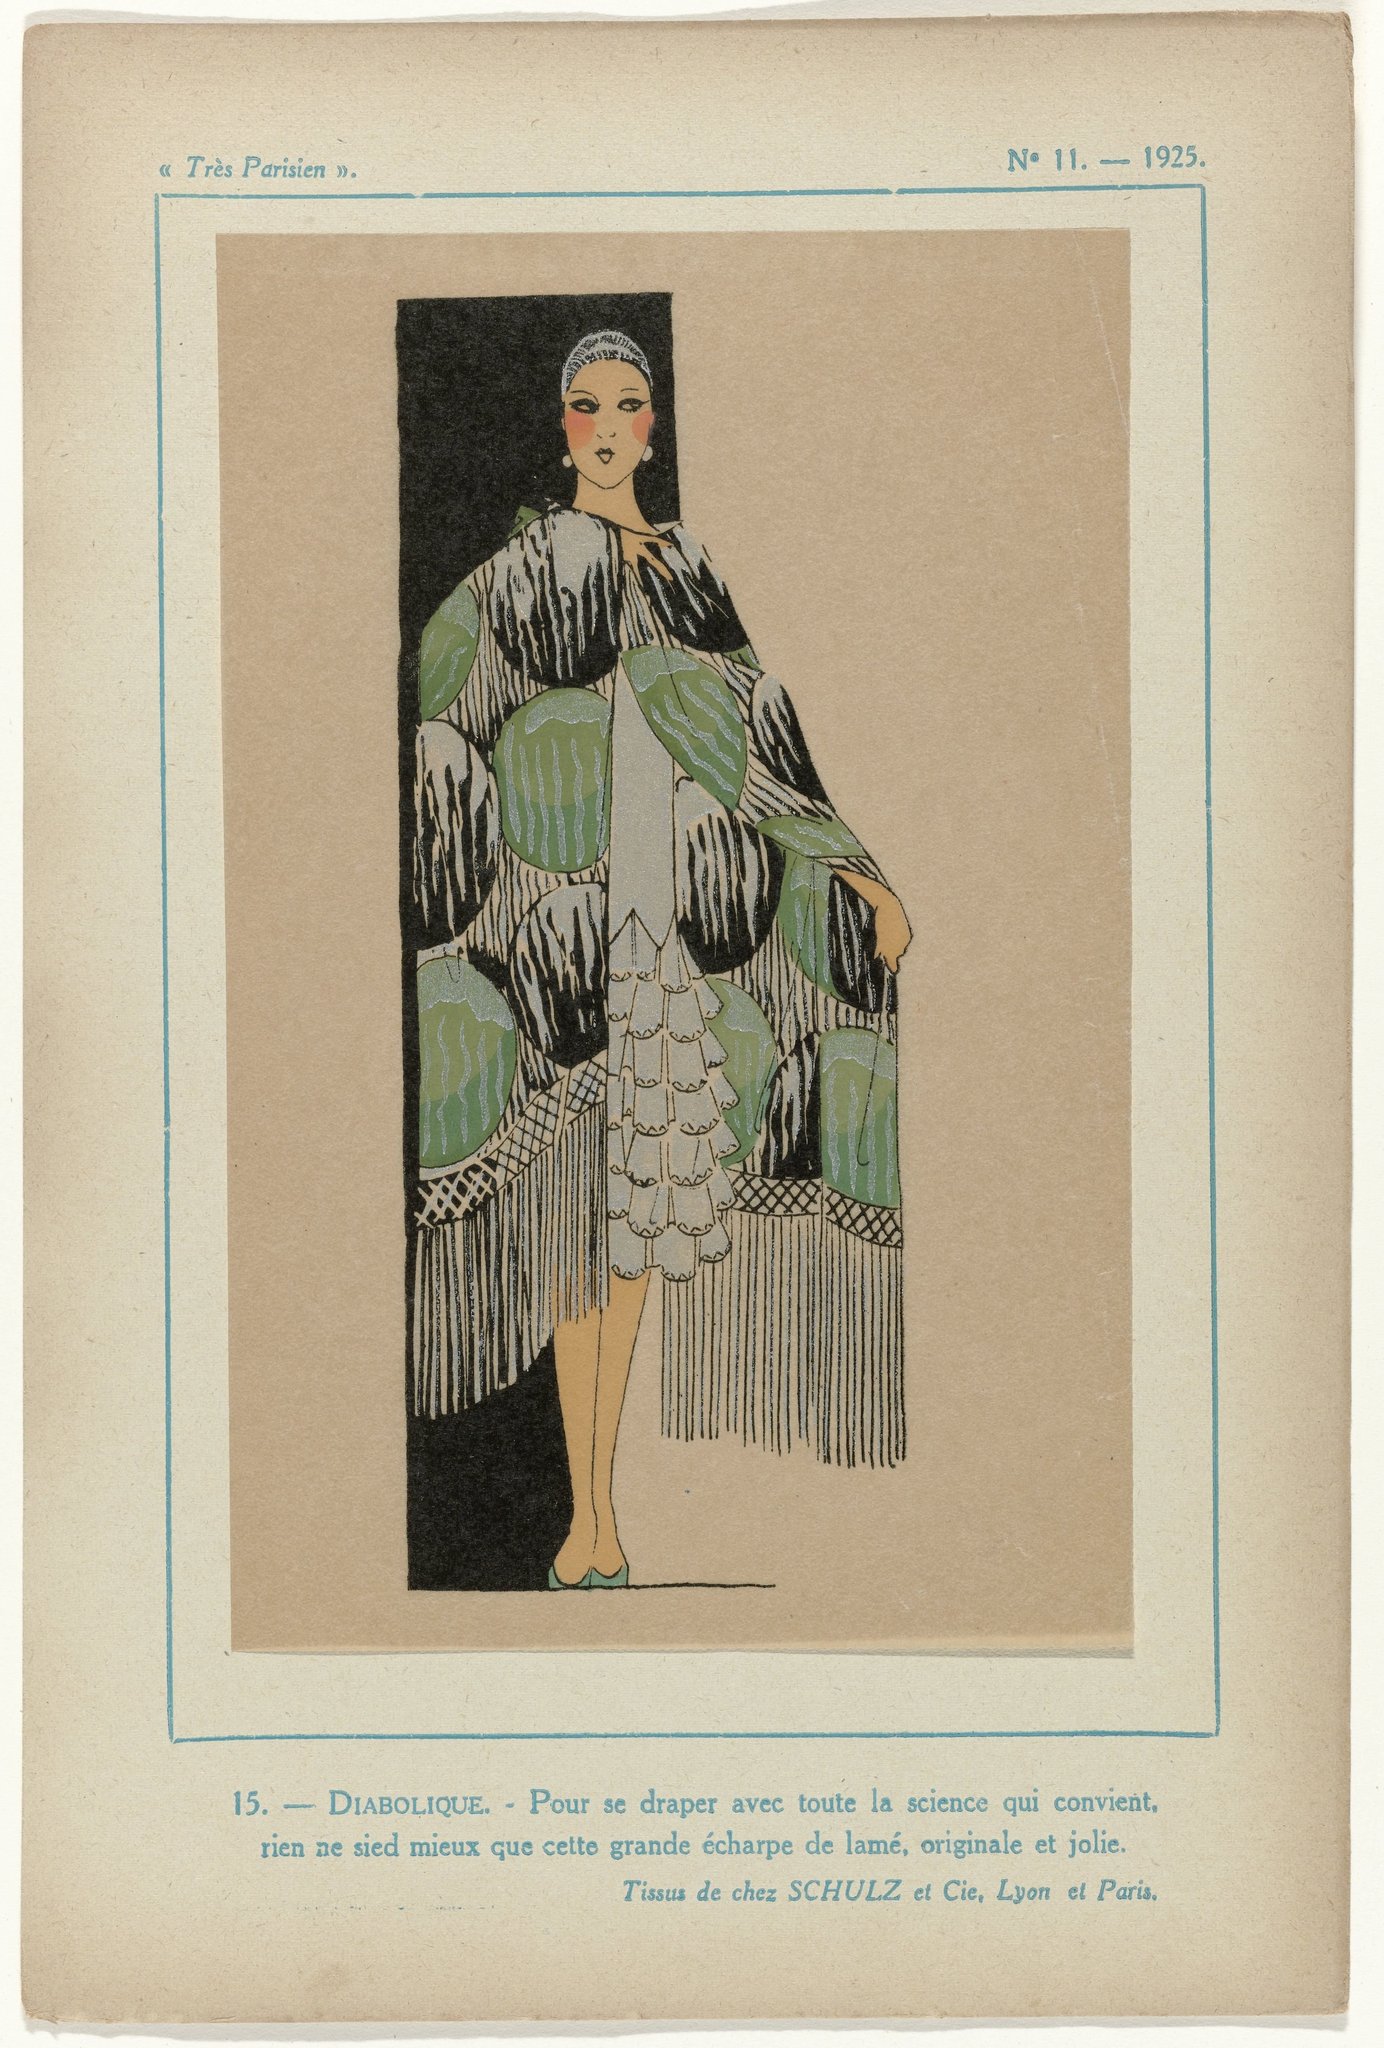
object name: fashion print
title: Très Parisien, 1925, No. 11, Pl. 15.- DIABOLIQUE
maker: g-p. joumard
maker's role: publisher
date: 1925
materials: paper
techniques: hand coloring, letterpress printing, lithography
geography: paris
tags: ear-rings (+ women's clothes), cape (+ women's clothes), fashion plates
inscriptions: caption: ‘15. - DIABOLIQUE. - Pour se draper avec toute la science qui convient, rien ne sied que cette grande écharpe de lamé, originale et jolie. Tissus de chez SCHULZ et Cie, Lyon et Paris.’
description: Grote omslagdoek van lamé, over een lichtgrijze japon. De stof is van de firma Schulz. Prent uit het modetijdschrift Très Parisien...La Mode, Le Chic, L'Élégance (1920-1936)